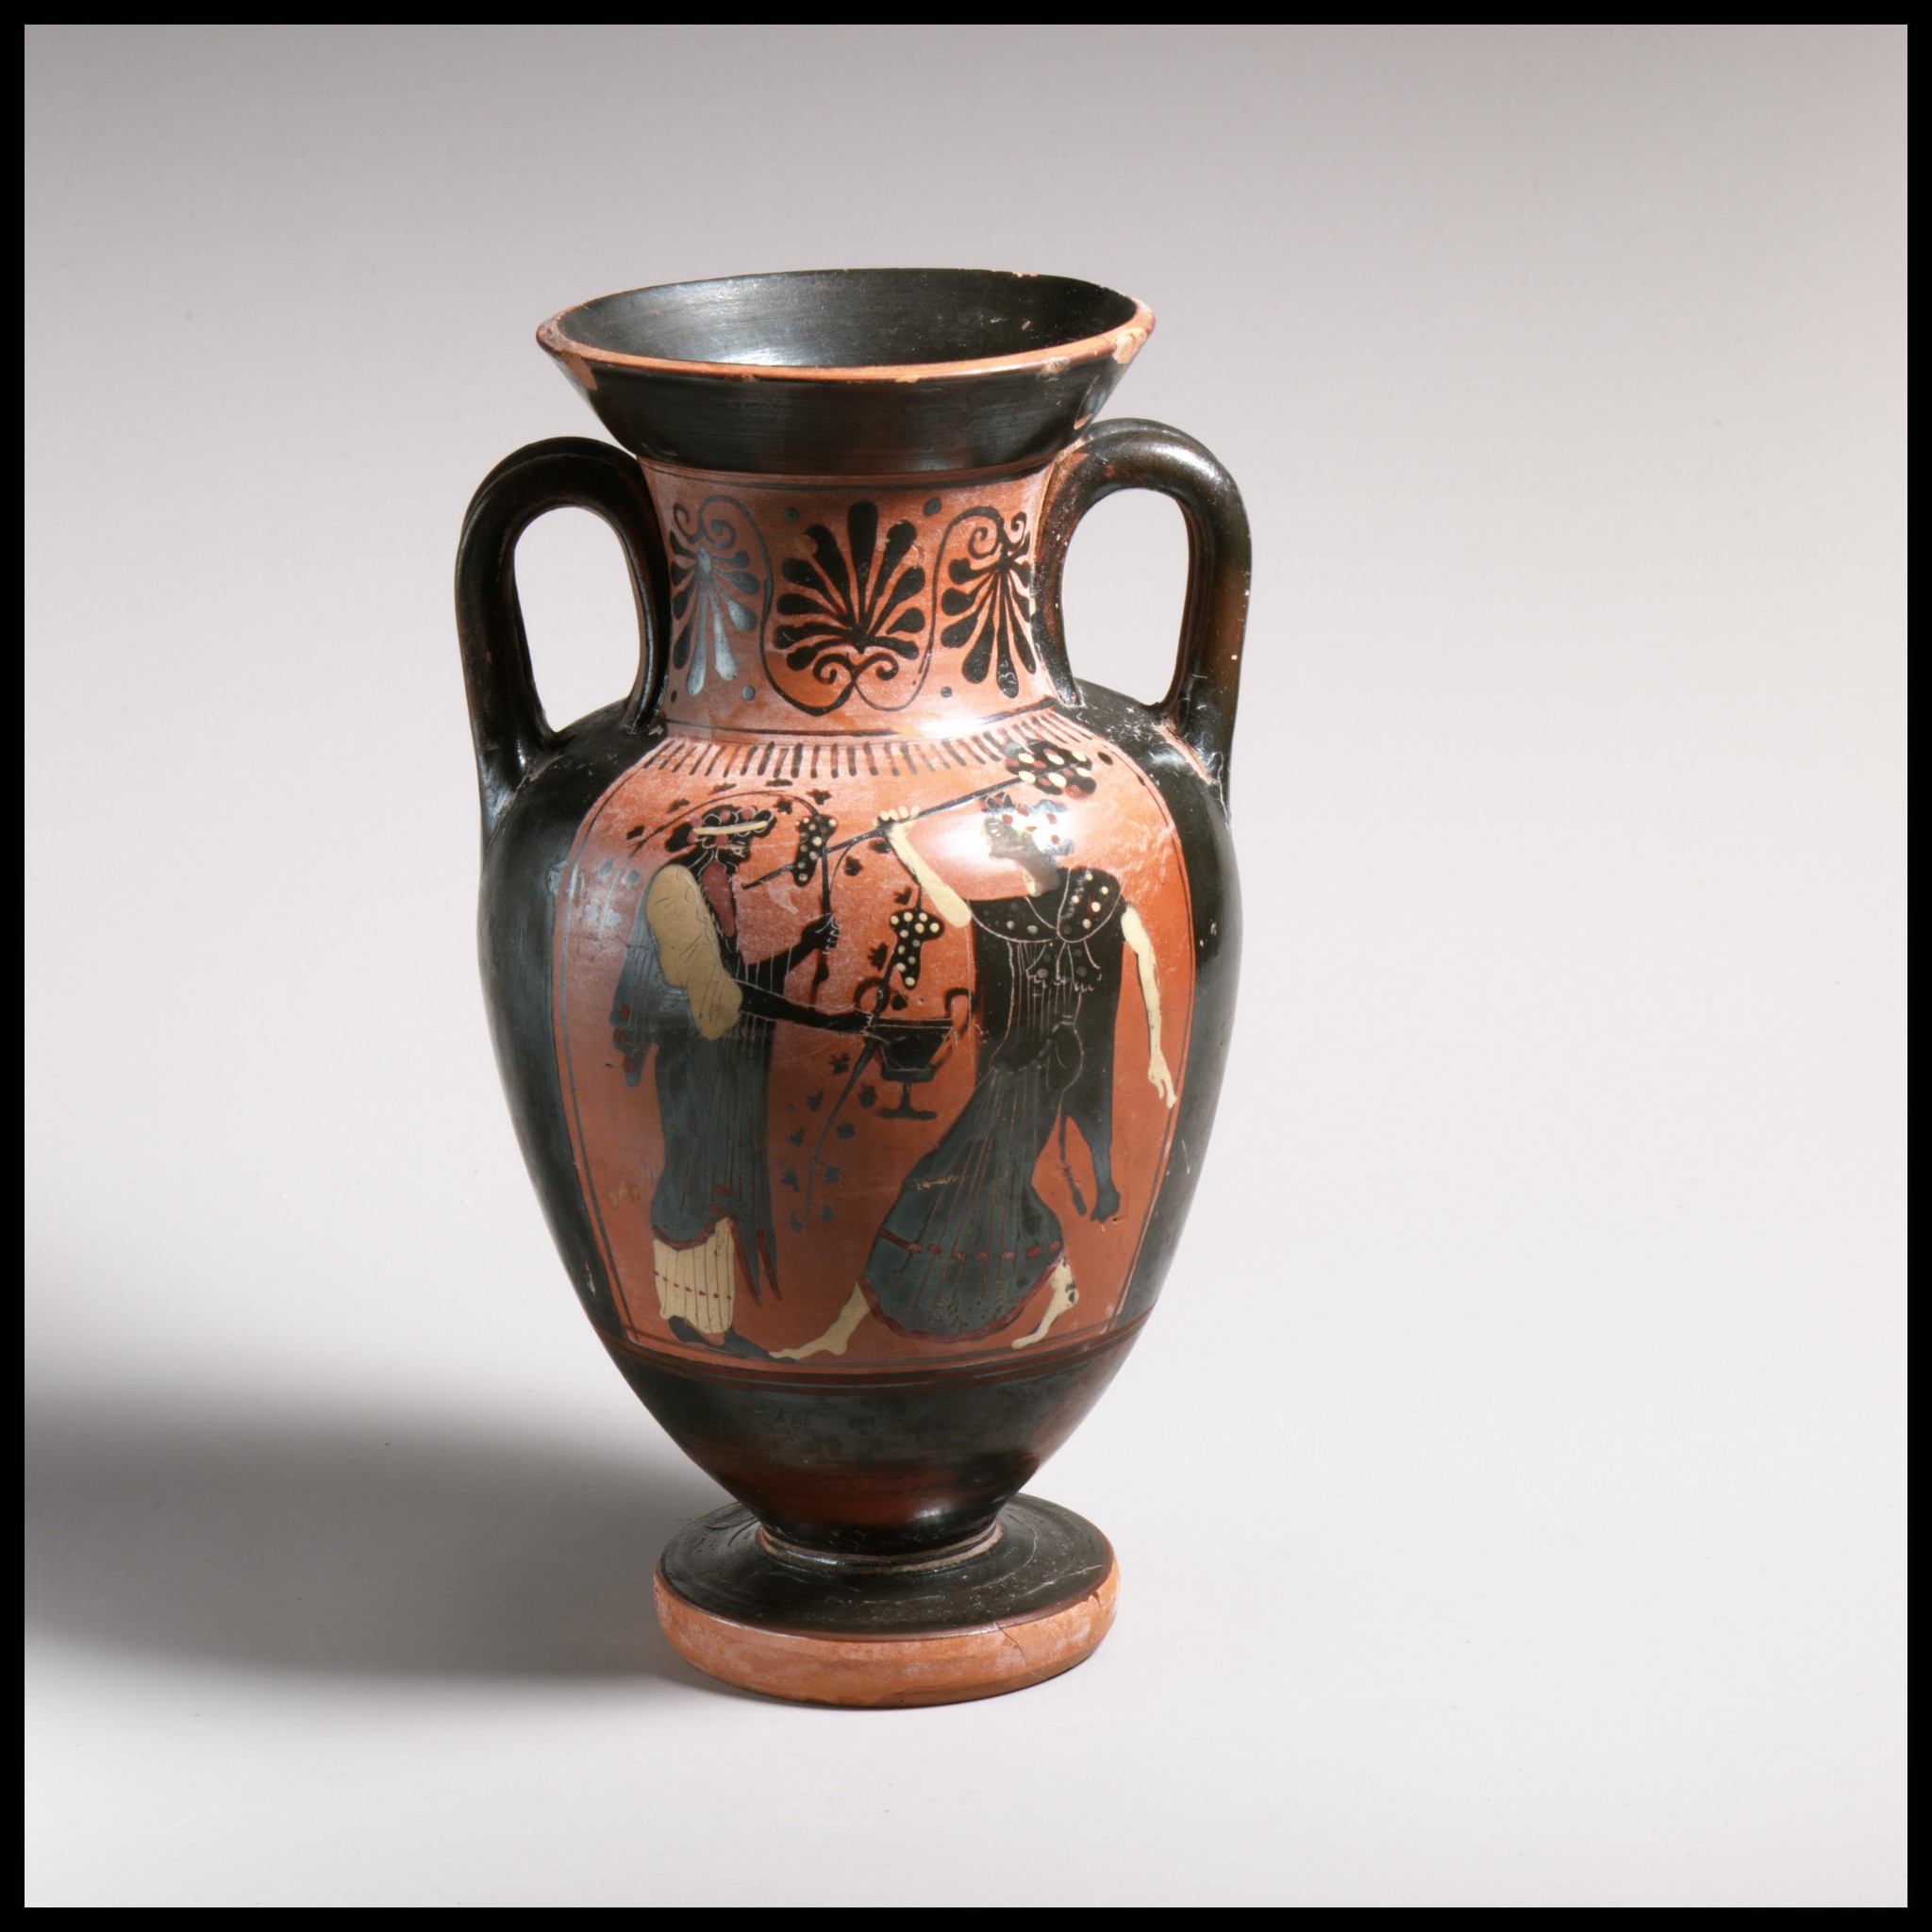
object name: neck amphora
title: Neck-amphora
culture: greek, attic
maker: diosphos painter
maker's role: artist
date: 500-468 BCE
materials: terracotta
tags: women,dionysus,maenads,satyrs